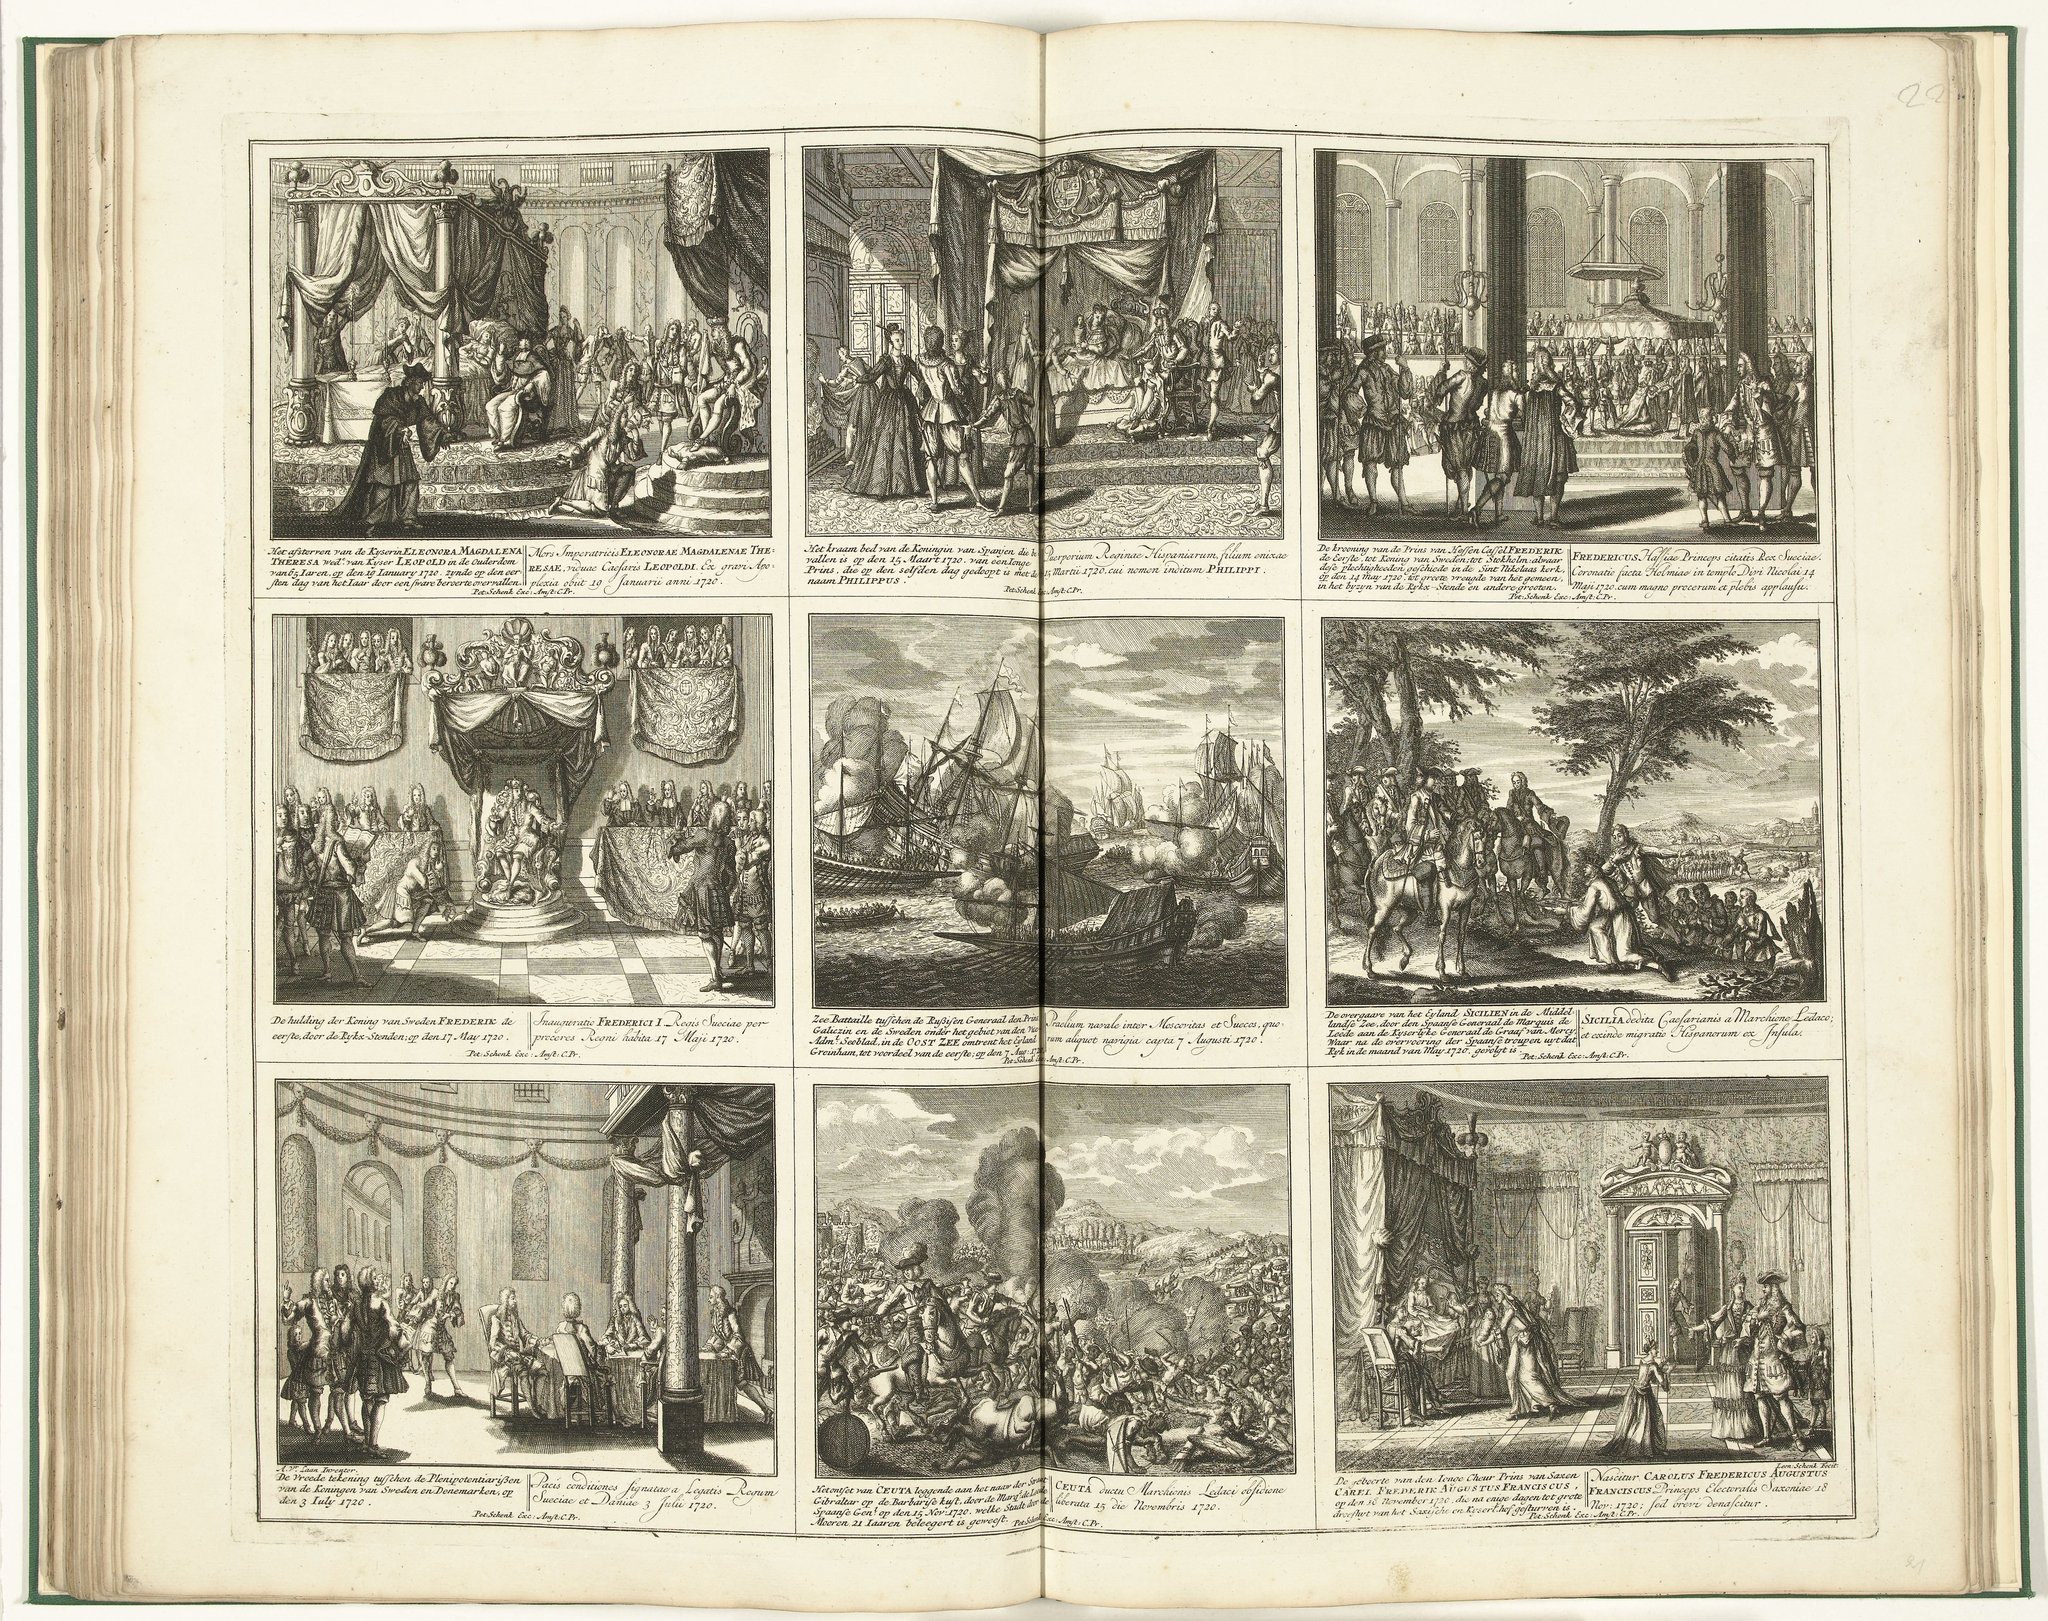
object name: print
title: Schouwburg van den Oorlog, Beginnende van Koning Karel den II. Tot op Koning Karel den III. Bestaande in IX. Historische Figuren op een Olifants Blad, als Veldslagen, Belegeringen te Water en te Lande, met de voornaamste Vestingen (...)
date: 1720-1722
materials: paper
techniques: etching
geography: amsterdam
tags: frederik i (koning van zweden), battle (+ naval force), coronation of a ruler, signing of peace treaty, concluding the peace, battle (+ land forces), confinement, birth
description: Blad met negen voorstellingen van gebeurtenissen uit het jaar 1720. Blad XXI in: Schouwburg van den oorlog (editie van 1720), het prentwerk met de gebundelde reeks van 31 platen over de Spaanse Successieoorlog.